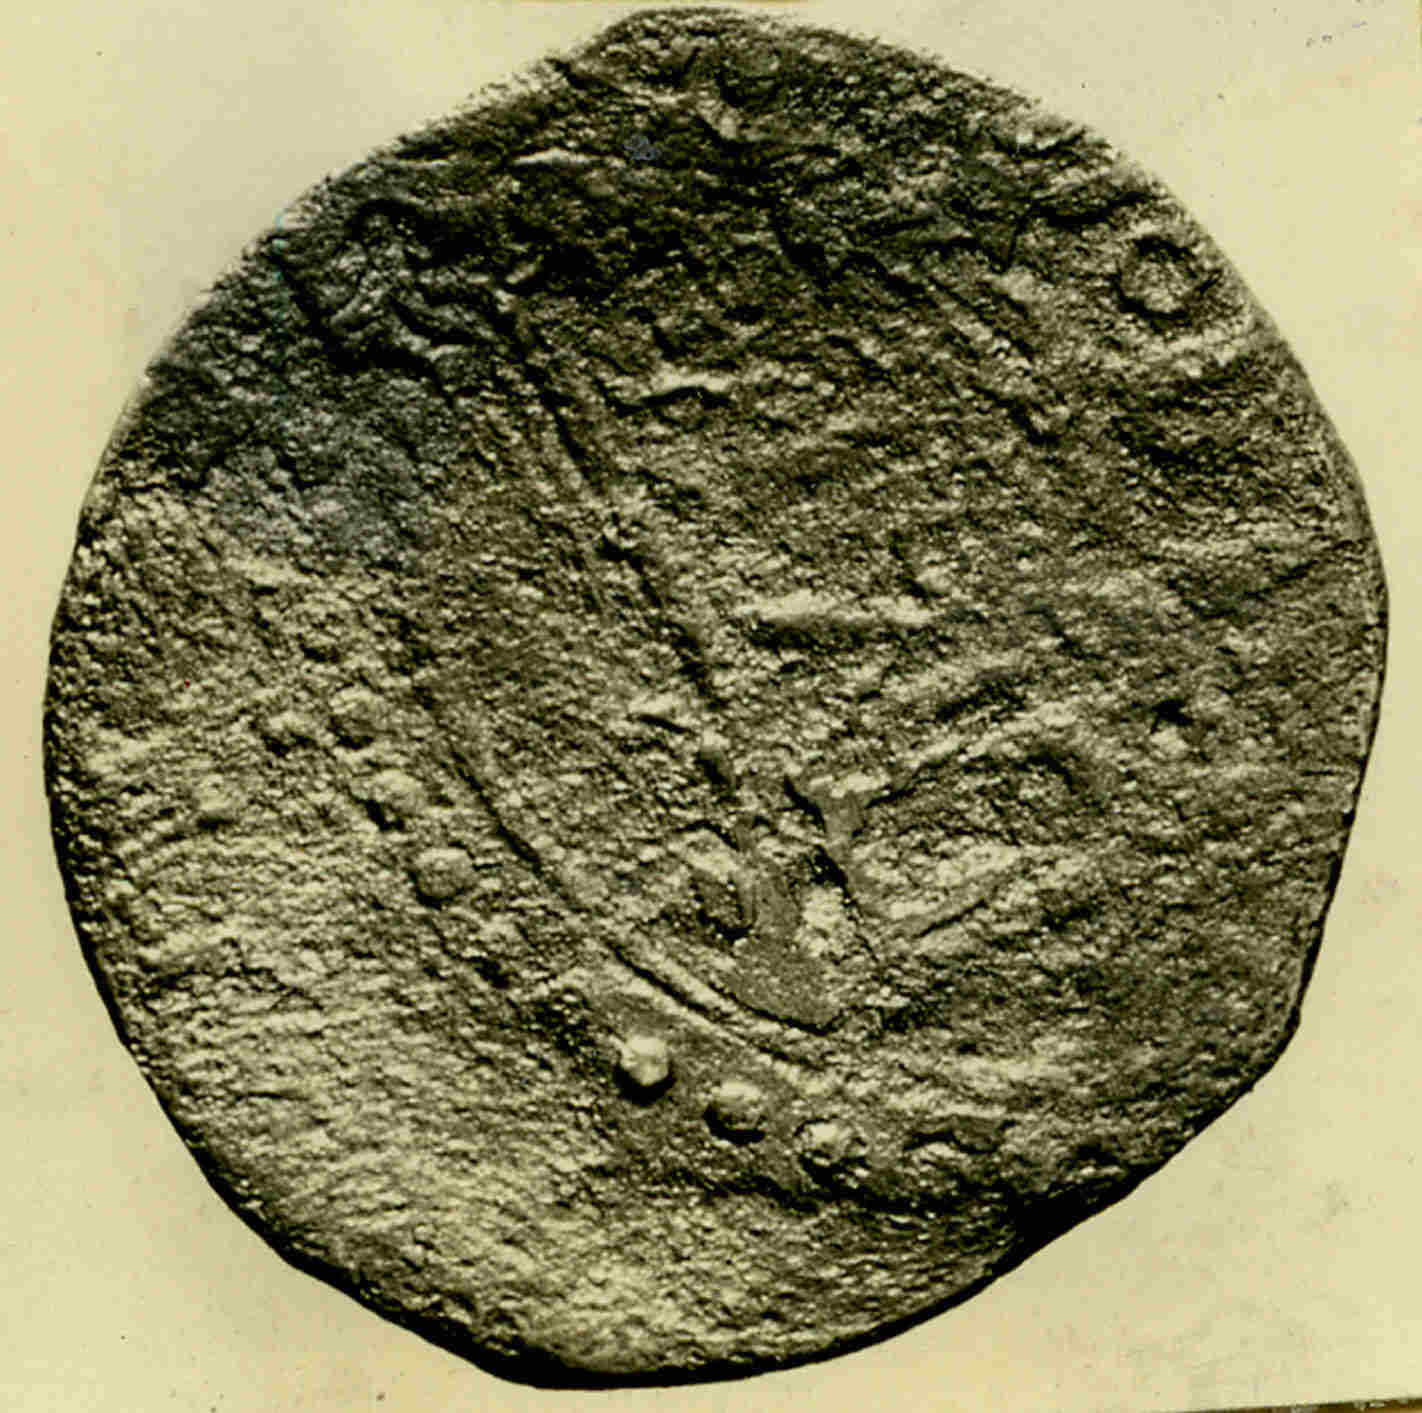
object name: coin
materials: copper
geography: iran